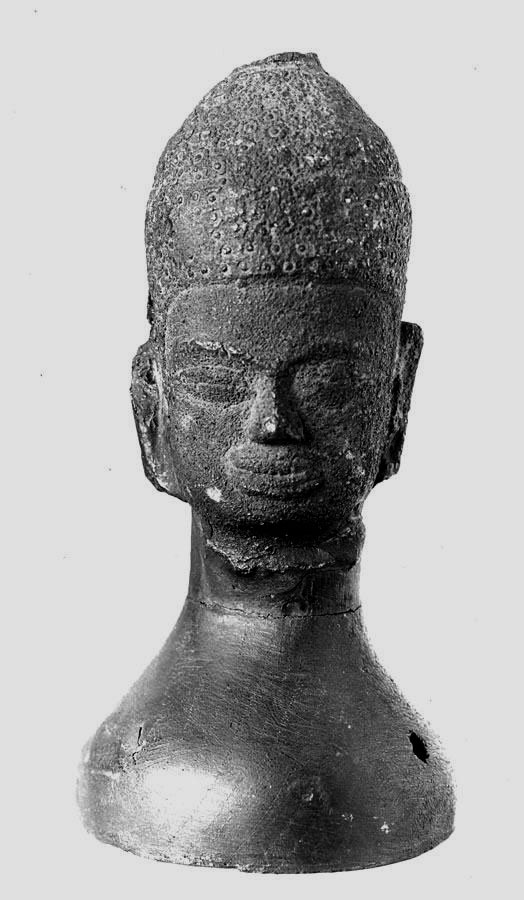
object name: head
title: Head of a Warrior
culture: cambodian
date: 801-900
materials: bronze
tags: soldiers,heads